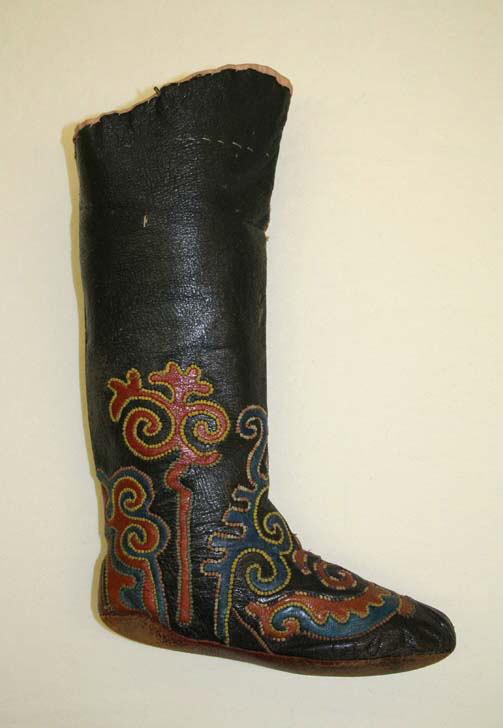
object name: boot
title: Boots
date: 1867-1900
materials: leather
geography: uzbekistan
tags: boots